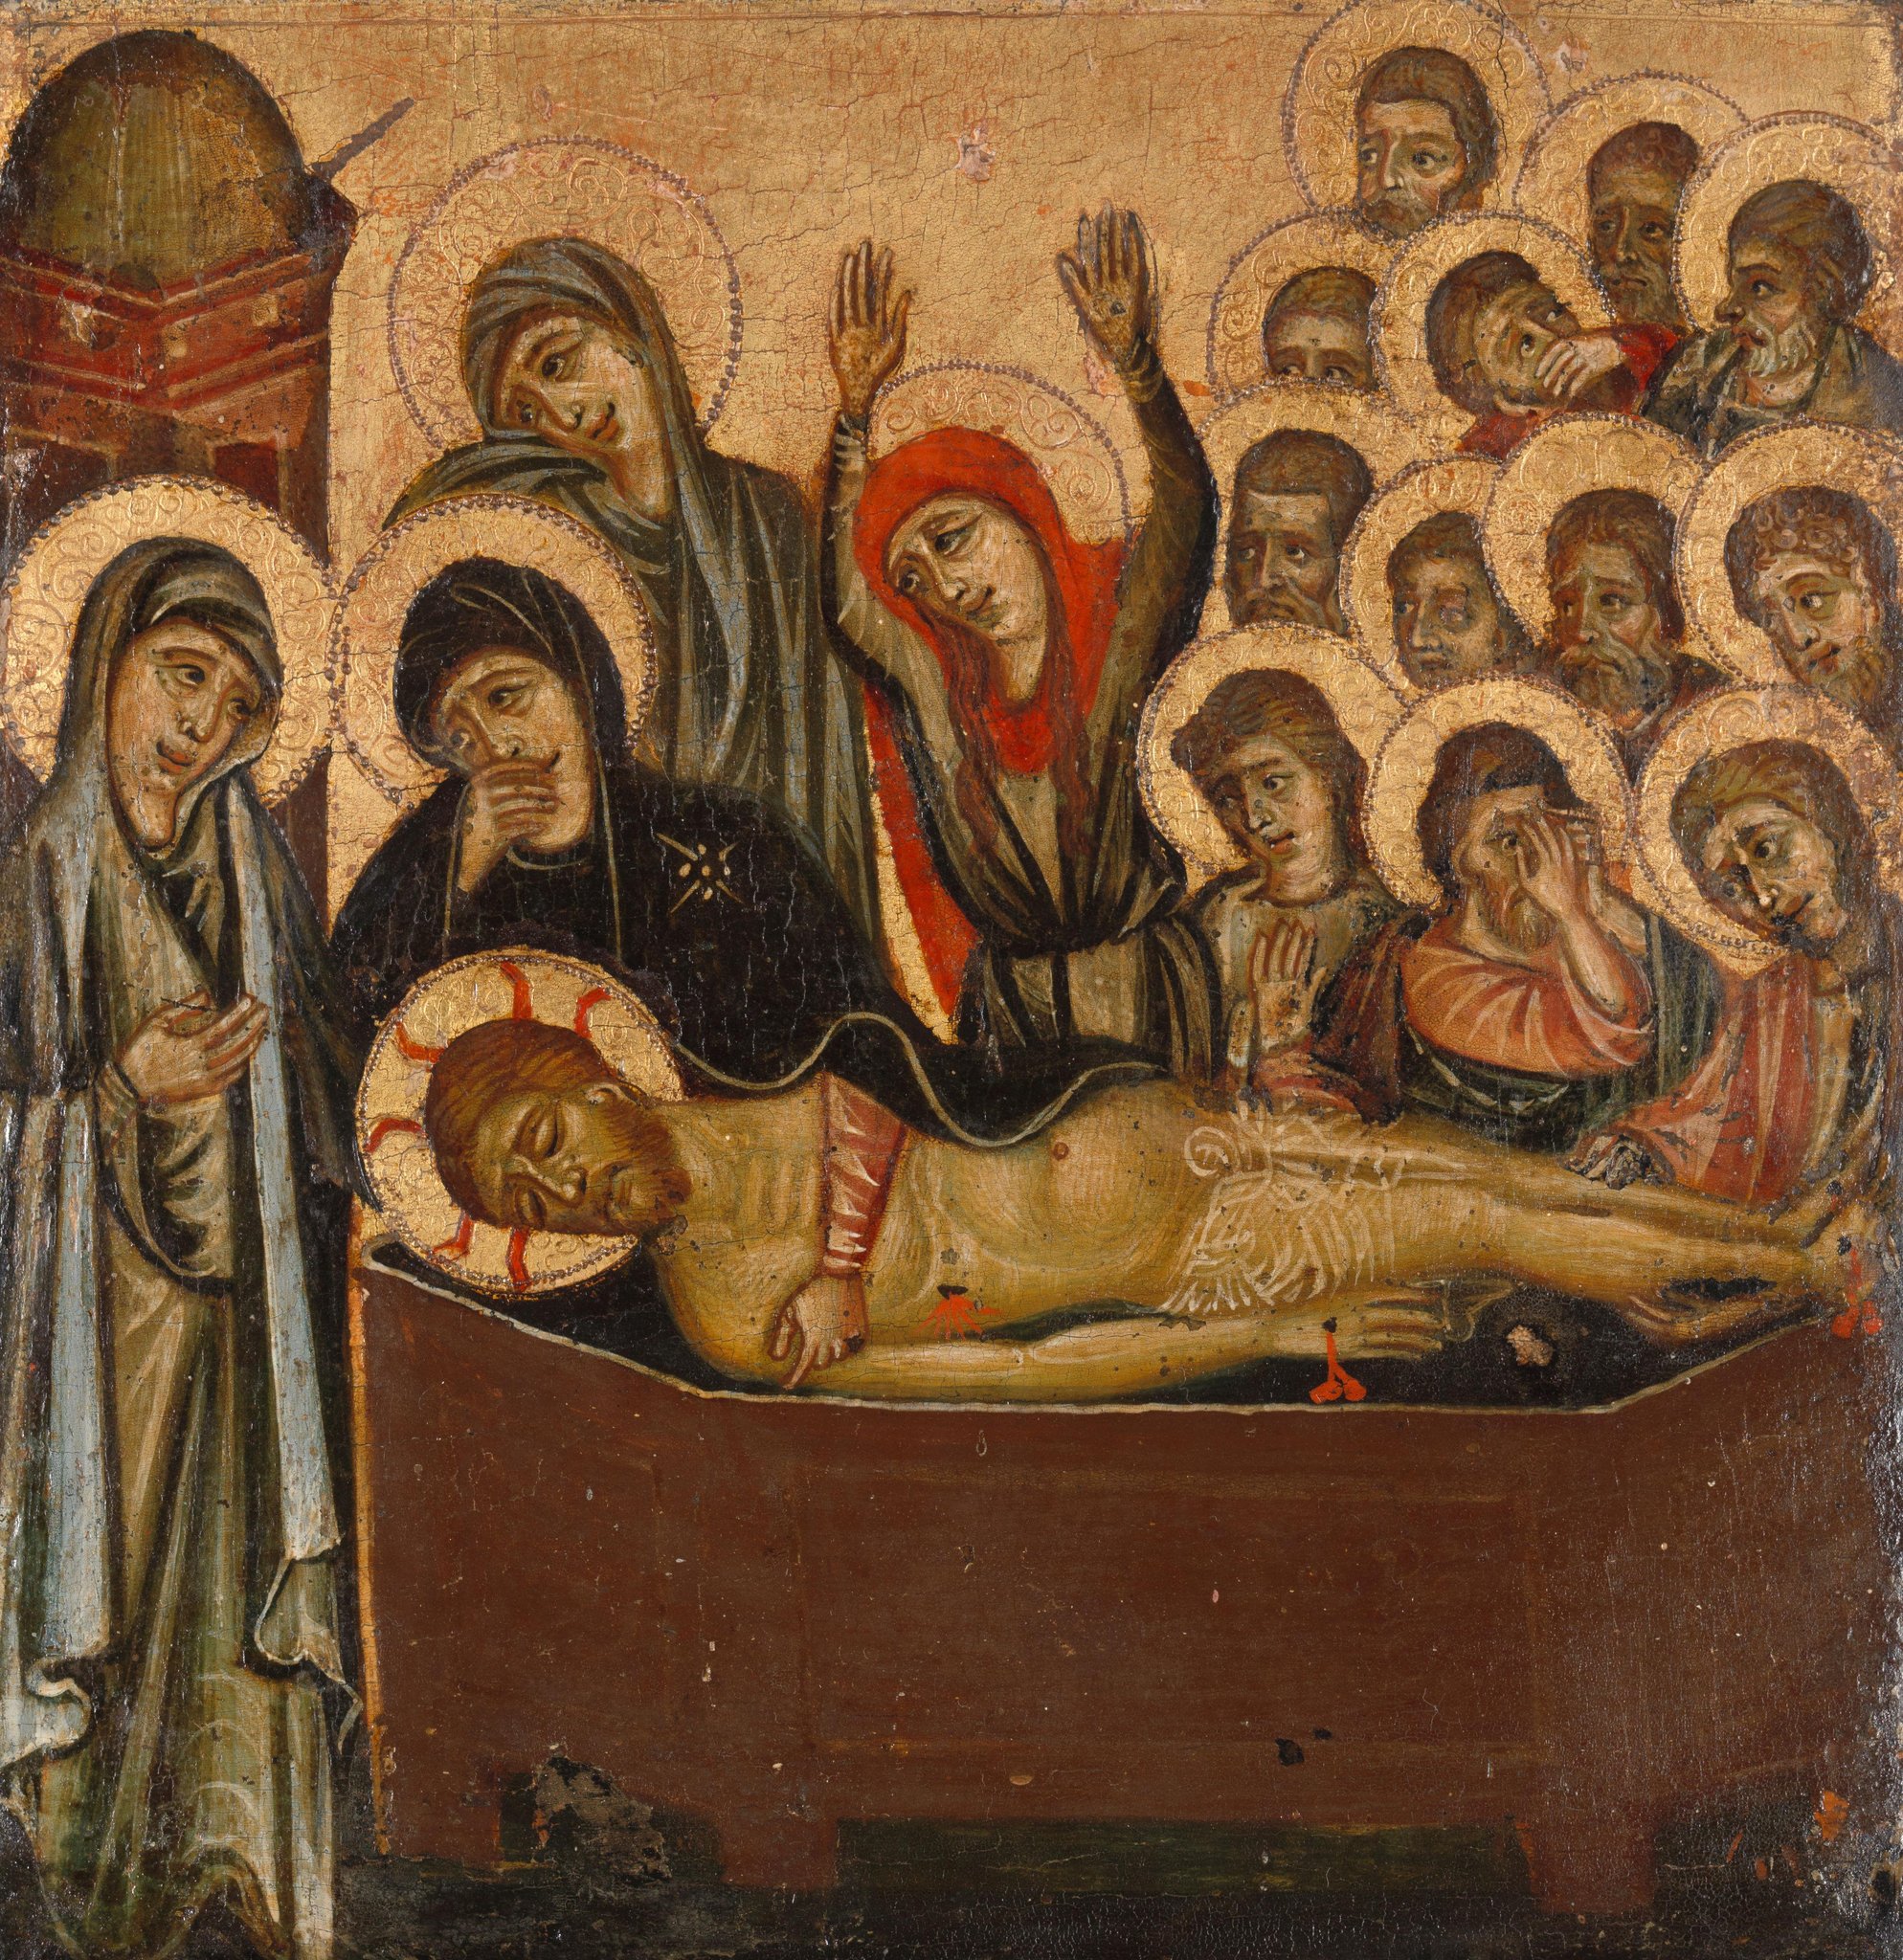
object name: painting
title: The Deposition and the Entombment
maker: corso di buono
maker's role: painter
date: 1290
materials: panel, paint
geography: pisa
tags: christ's entombment (possibly by angels)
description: These two panels are probably fragments from a larger ensemble devoted to the Passion of Christ. The artist followed established conventions for depicting grief and sorrow through gesture. This approach was characteristic of the stiff, rather formulaic style derived from Greek and Byzantine models that was prevalent in 13th-century Italy.